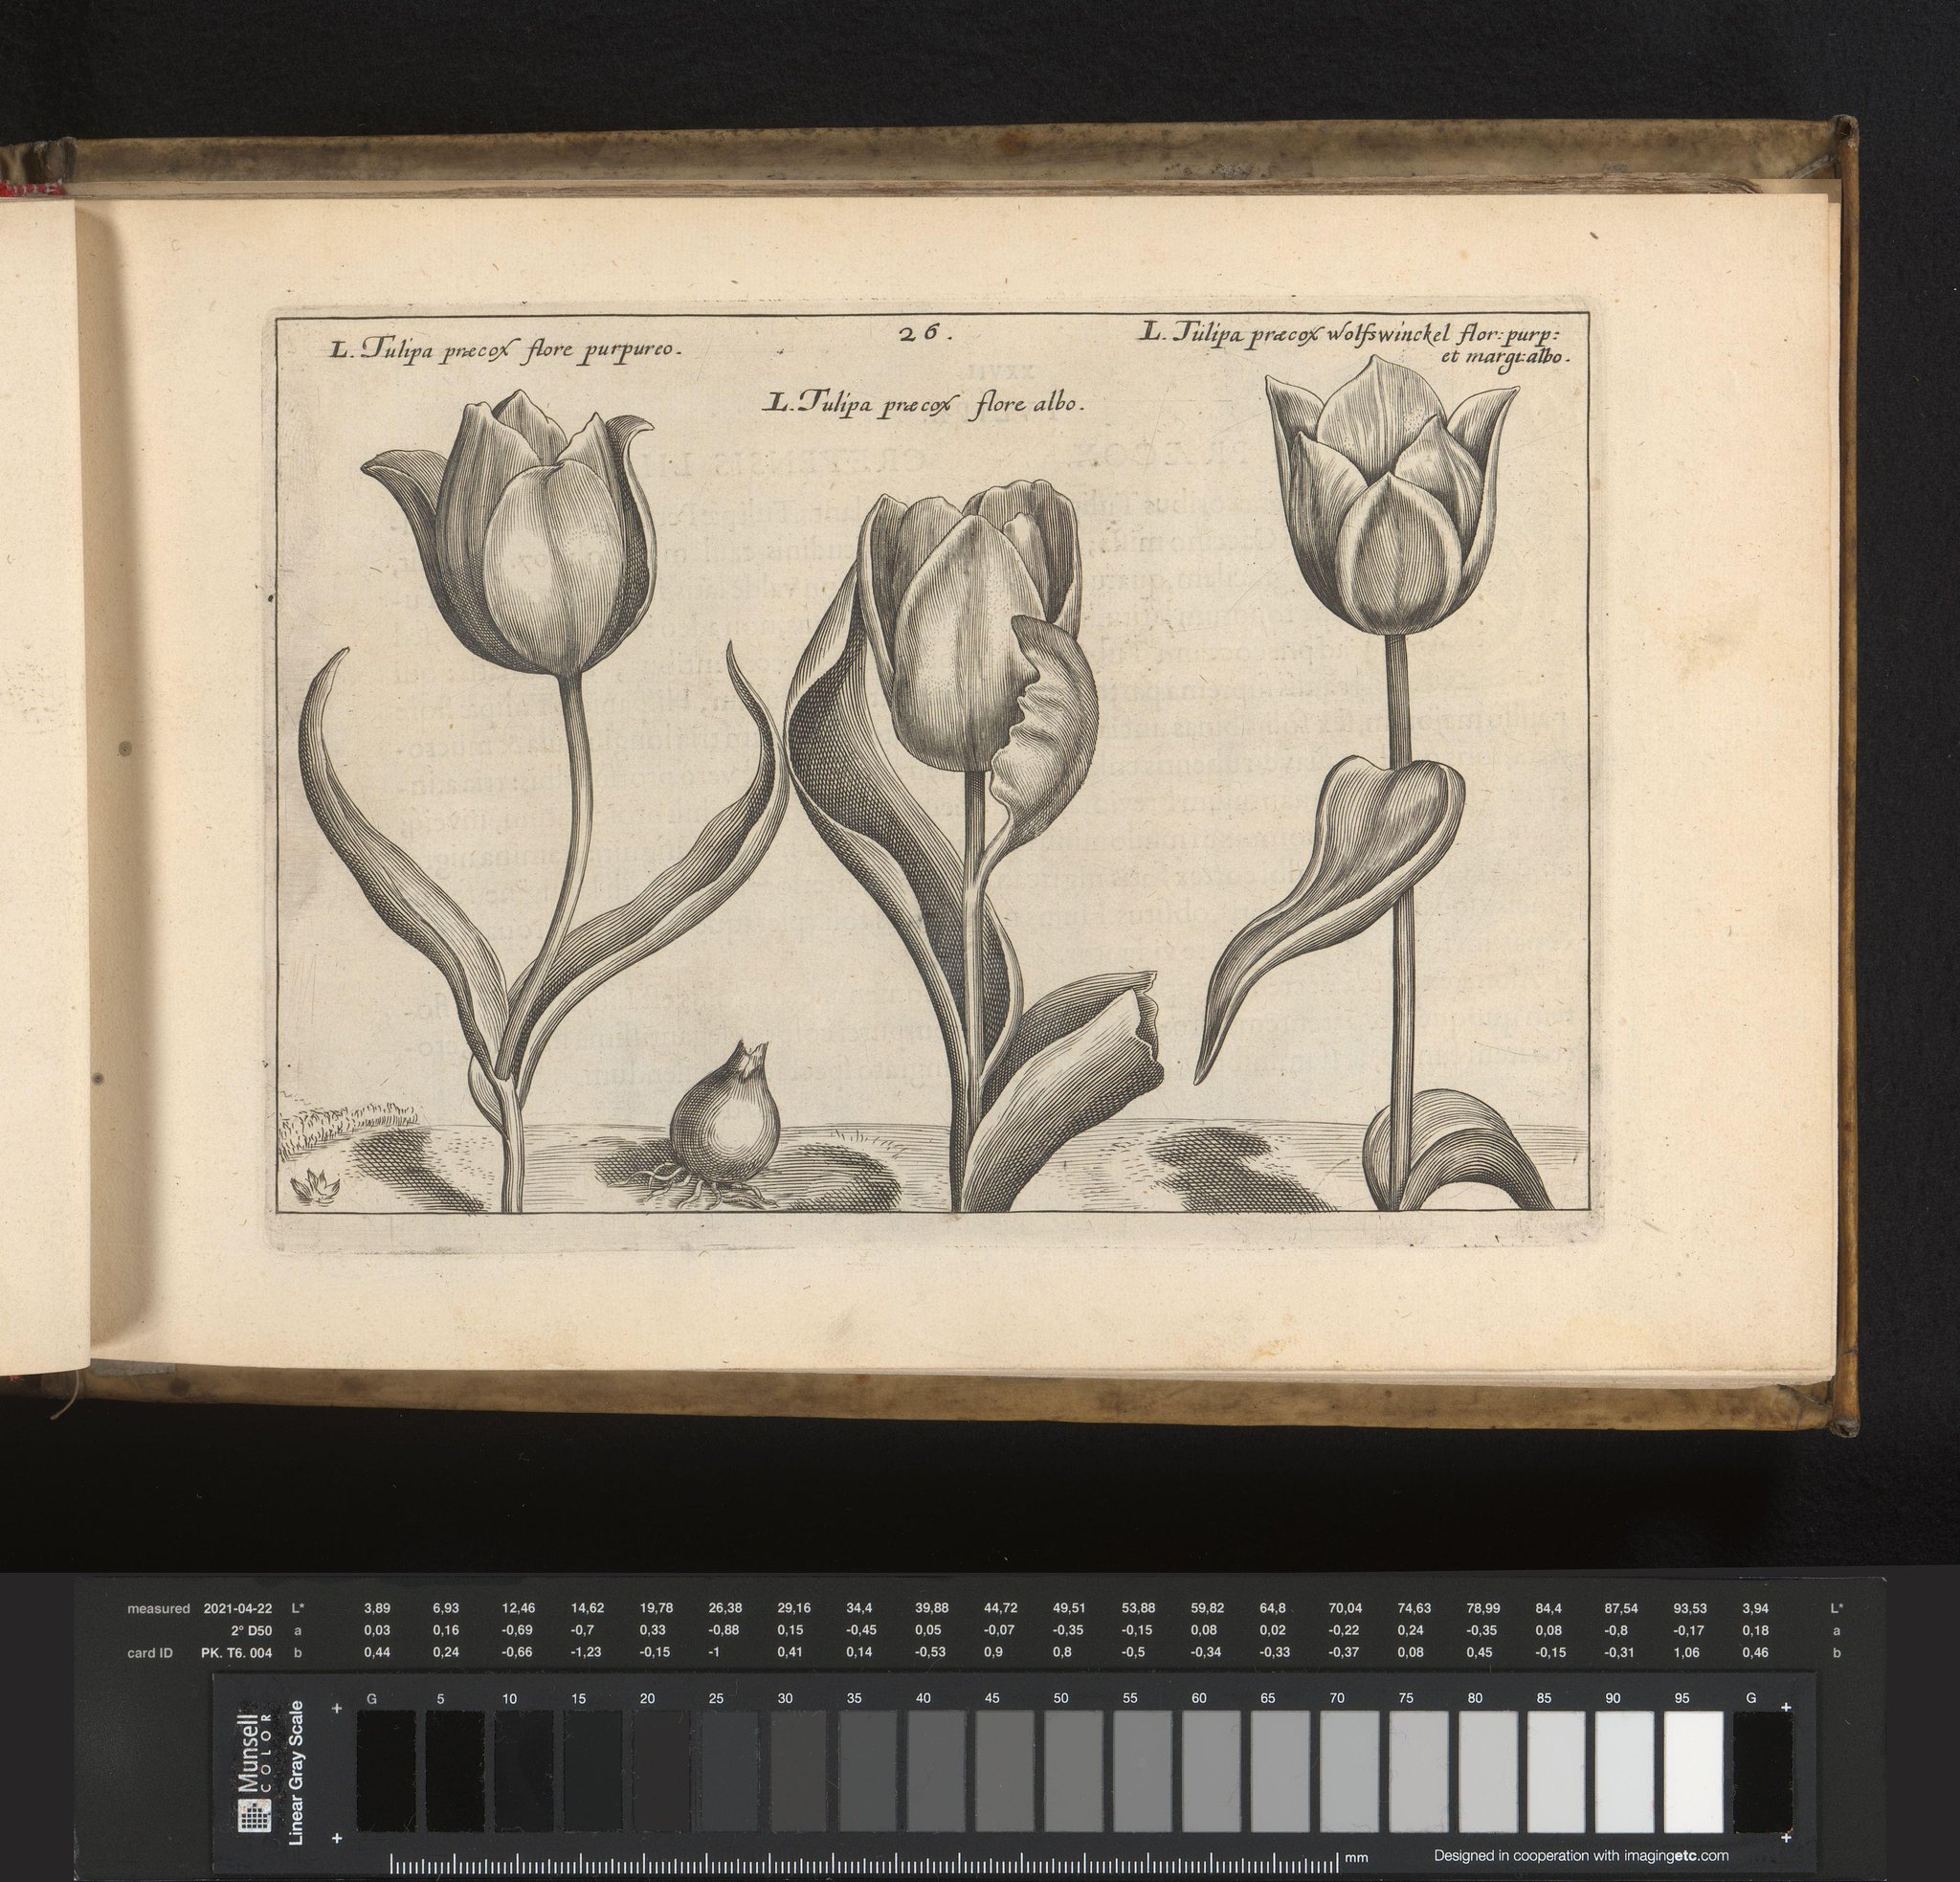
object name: book illustration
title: Drie kleurvarianten van Tulipa praecox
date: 1617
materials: paper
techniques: engraving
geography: arnhem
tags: flowers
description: Prent uit: Passe, Crispijn van de (II). Hortus floridus in quo rariorum & minus vulgarium florum icones ad vivam veramque formam. Arnhem: Johannes Janssonius, 1617.